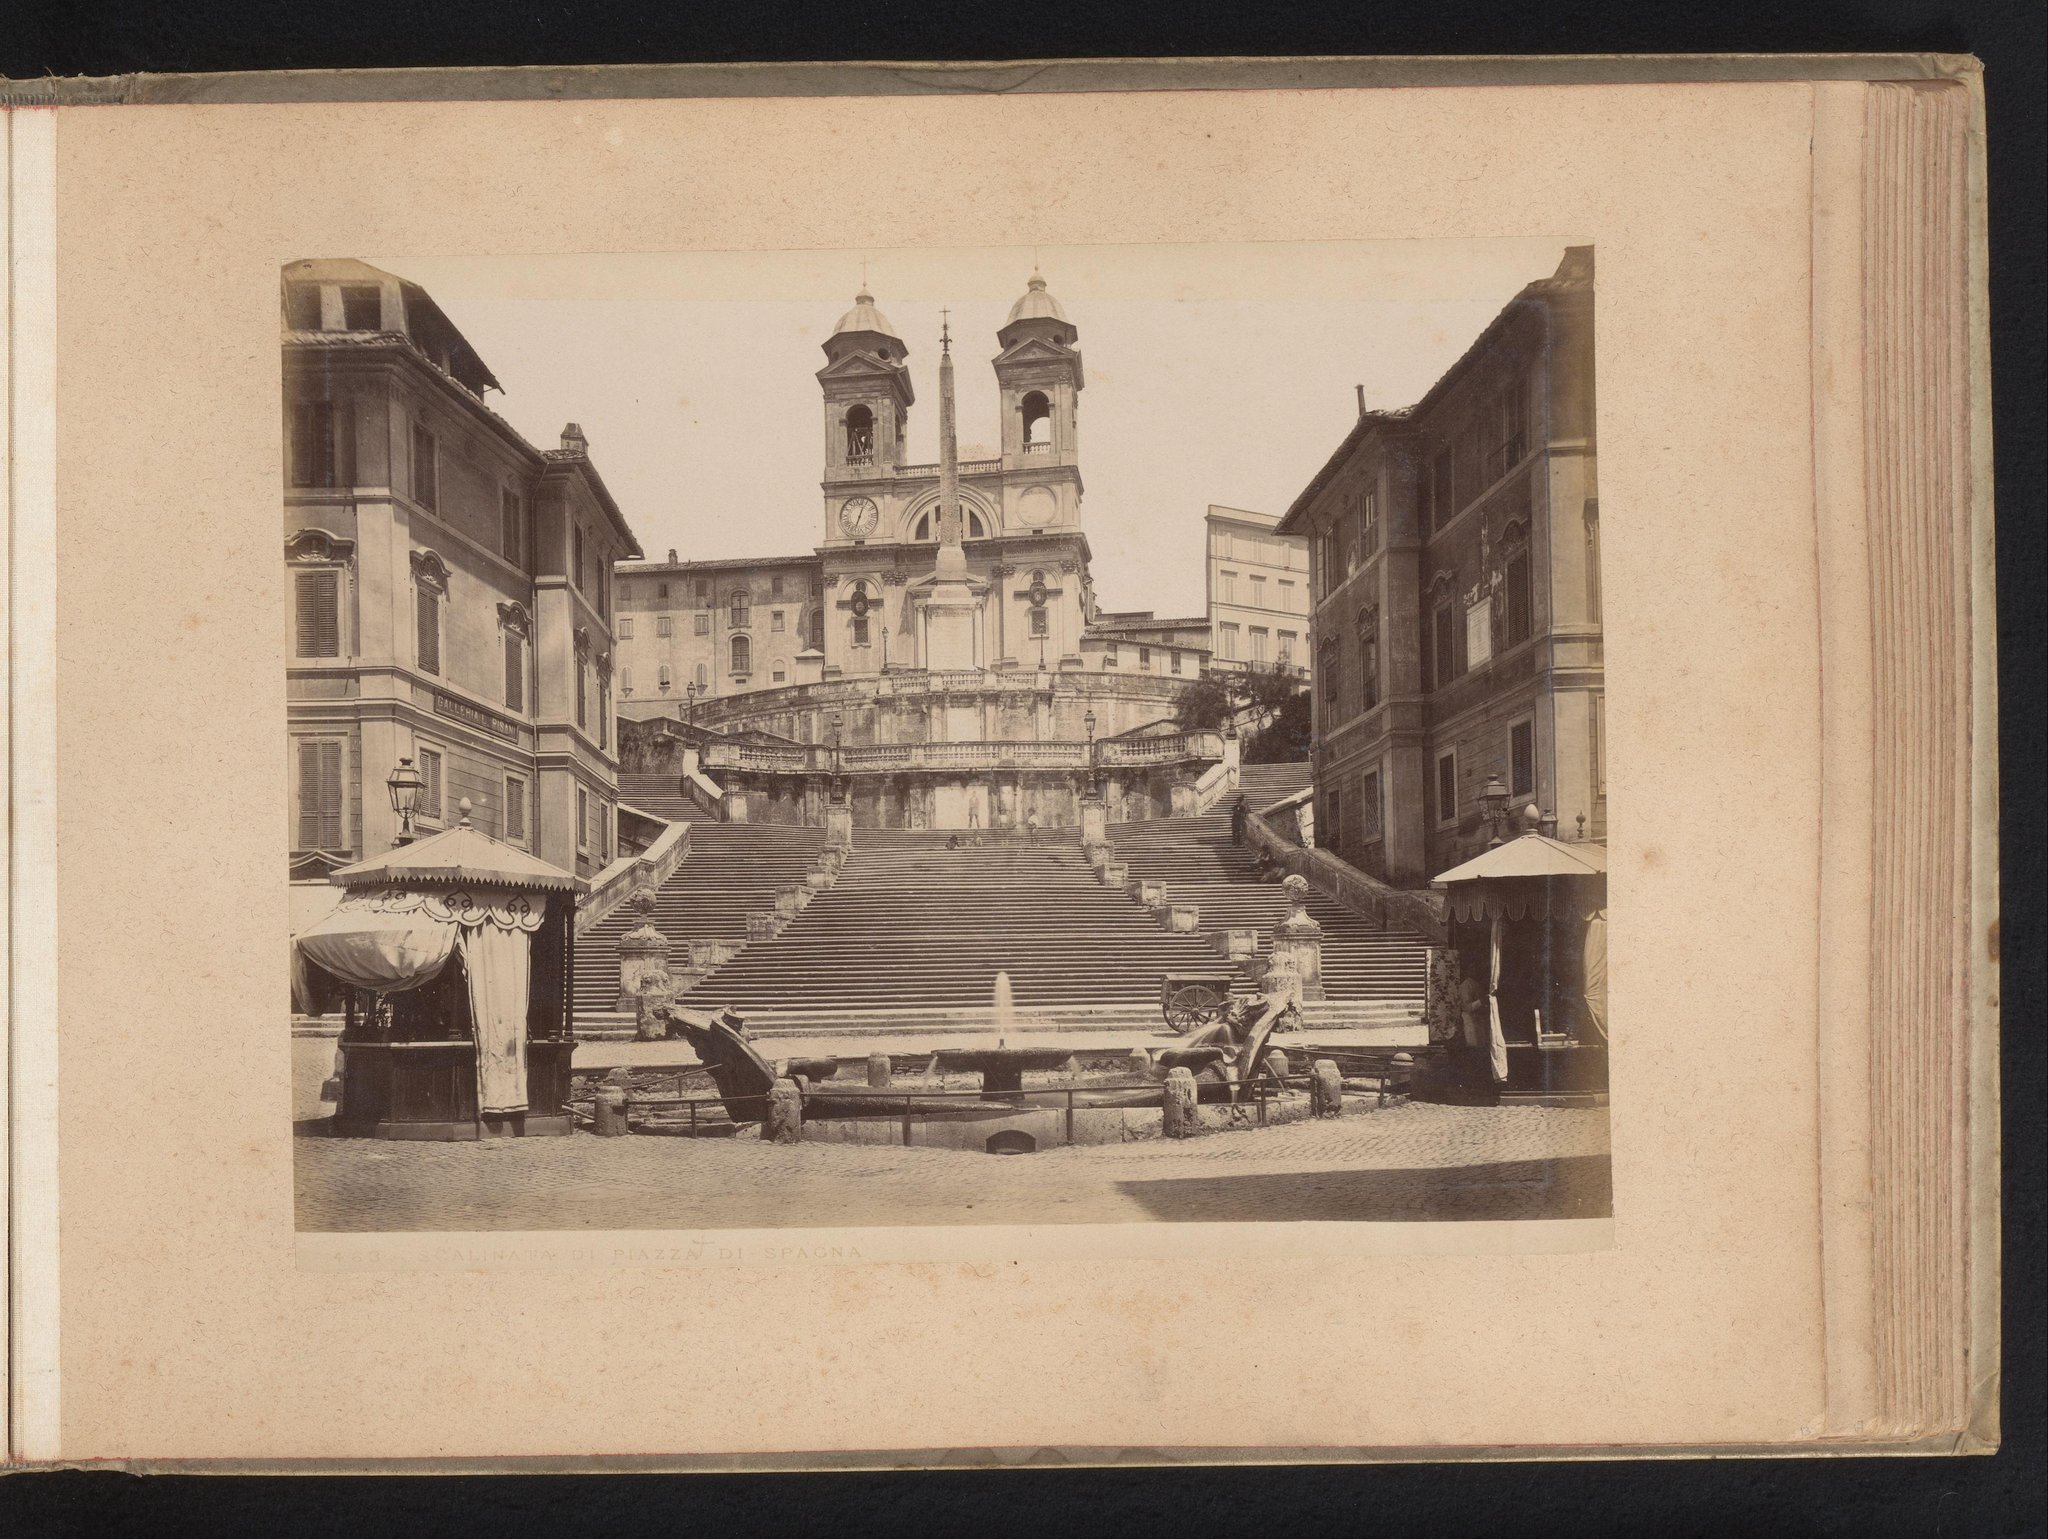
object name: album leaf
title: Gezicht op de Spaanse trappen aan het Piazza di Spagna in Rome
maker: Anonymous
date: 1870-1895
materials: cardboard, photographic support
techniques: albumen print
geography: rome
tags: square, place, circus, etc., sloping street; street with steps or stairs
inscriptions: inscription: ‘463 SCALINATA DI PIAZZA DI SPAGNA’